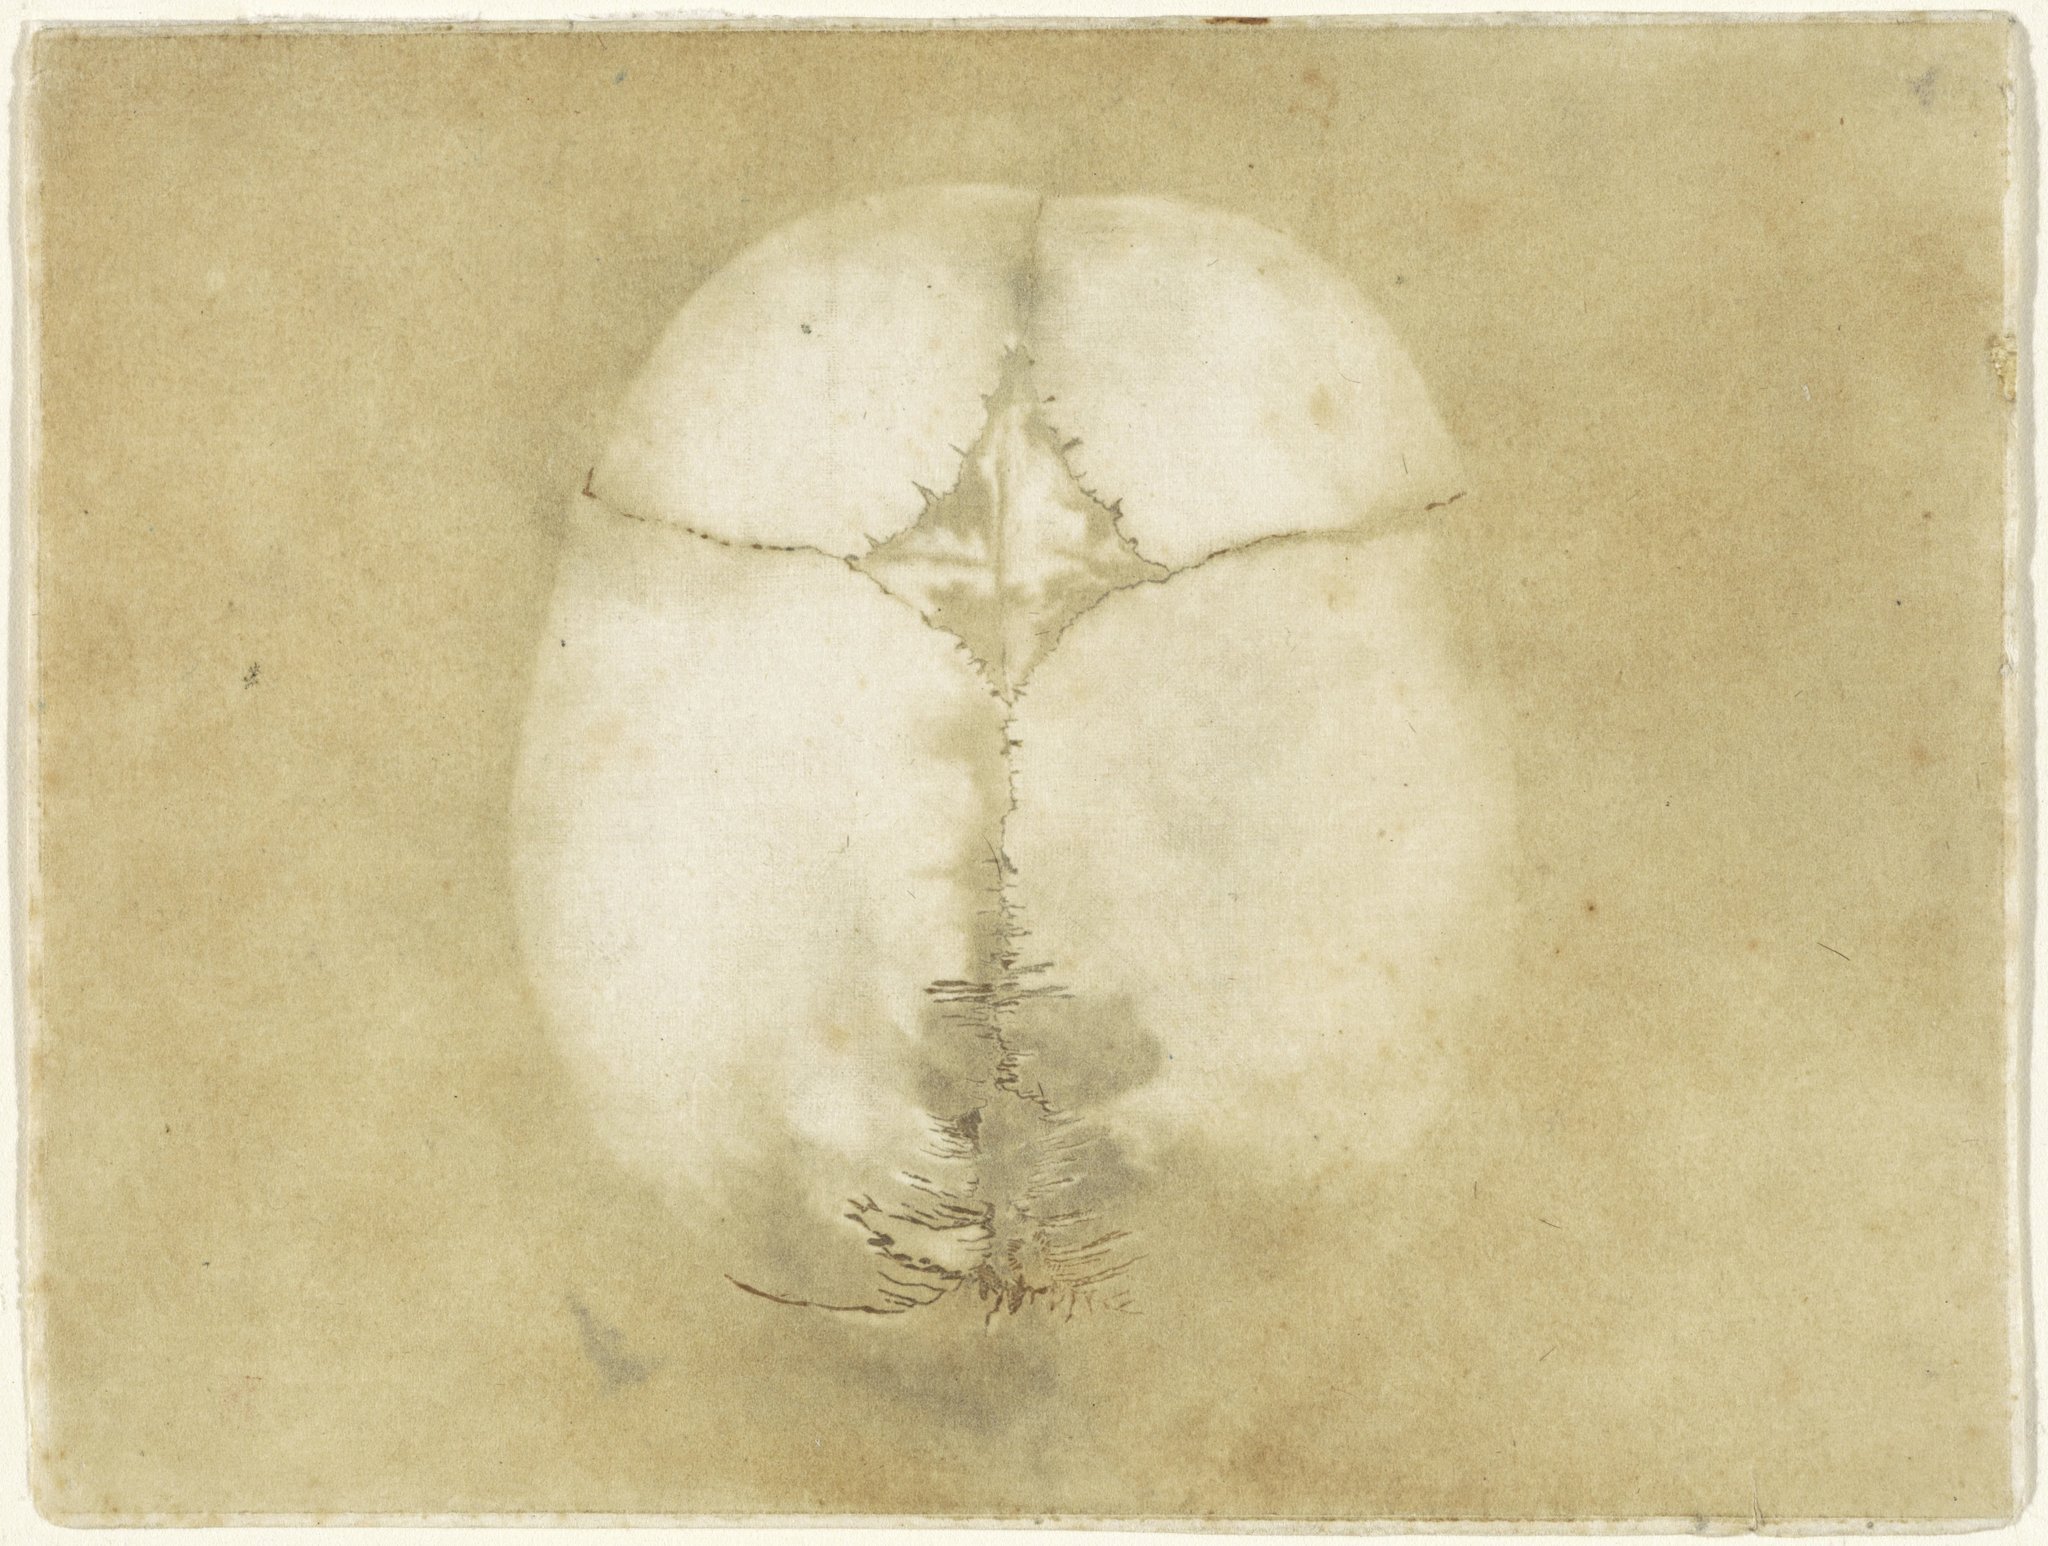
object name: print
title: Prints of the Brain and the Heart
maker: jan l admiral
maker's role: draughtsman, print maker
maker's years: 1699-1773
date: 1733-1738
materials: paper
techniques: color etching, mezzotint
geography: amsterdam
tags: (human) skull, other anatomical details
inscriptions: collector's mark: Lugt 2228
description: Around 1735 Jan l’Admiral printed several remarkable anatomical prints in colour, among others on commission for the celebrated physician Frederik Ruysch. For his illustrations of the cerebral membrane (the skull of an unborn child) and a human heart he experimented with ever different colours, and made various versions of them. The objective was to provide medical practitioners with the most precise and realistic images possible.